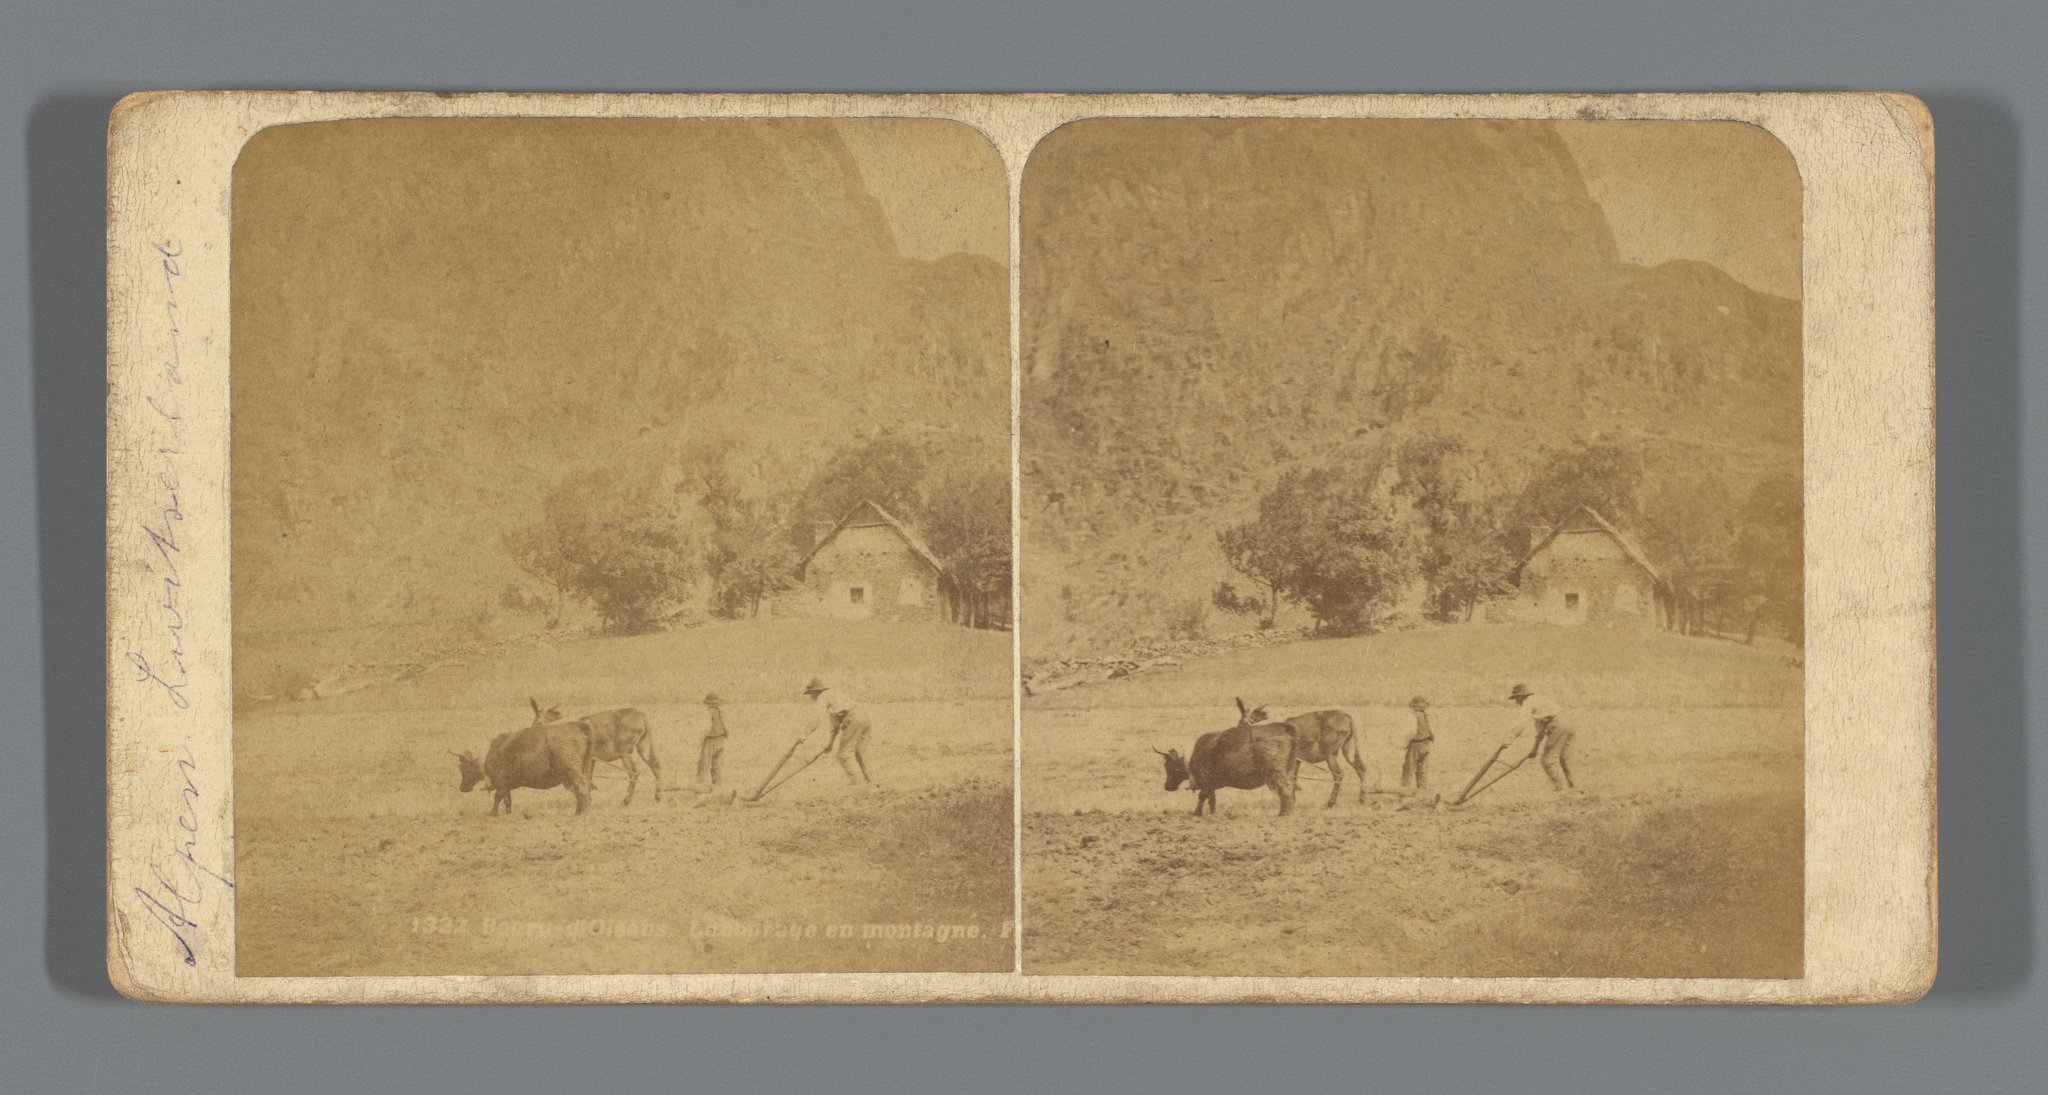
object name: stereograph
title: Aardrijkskundige Beeldengalerij, verzameld door M.J. Broekhuijsen, Hoofd eener school te Amsterdam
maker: martien johan broekhuijsen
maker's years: 1871-1956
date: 1905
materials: photographic support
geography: amsterdam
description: Onderdeel van een groep van 52 stereofoto's gebruikt in het lager onderwijs als aanvulling op schoolplaten. De gehele reeks bestond uit 274 nummers in 10 categorieën (A t/m K).